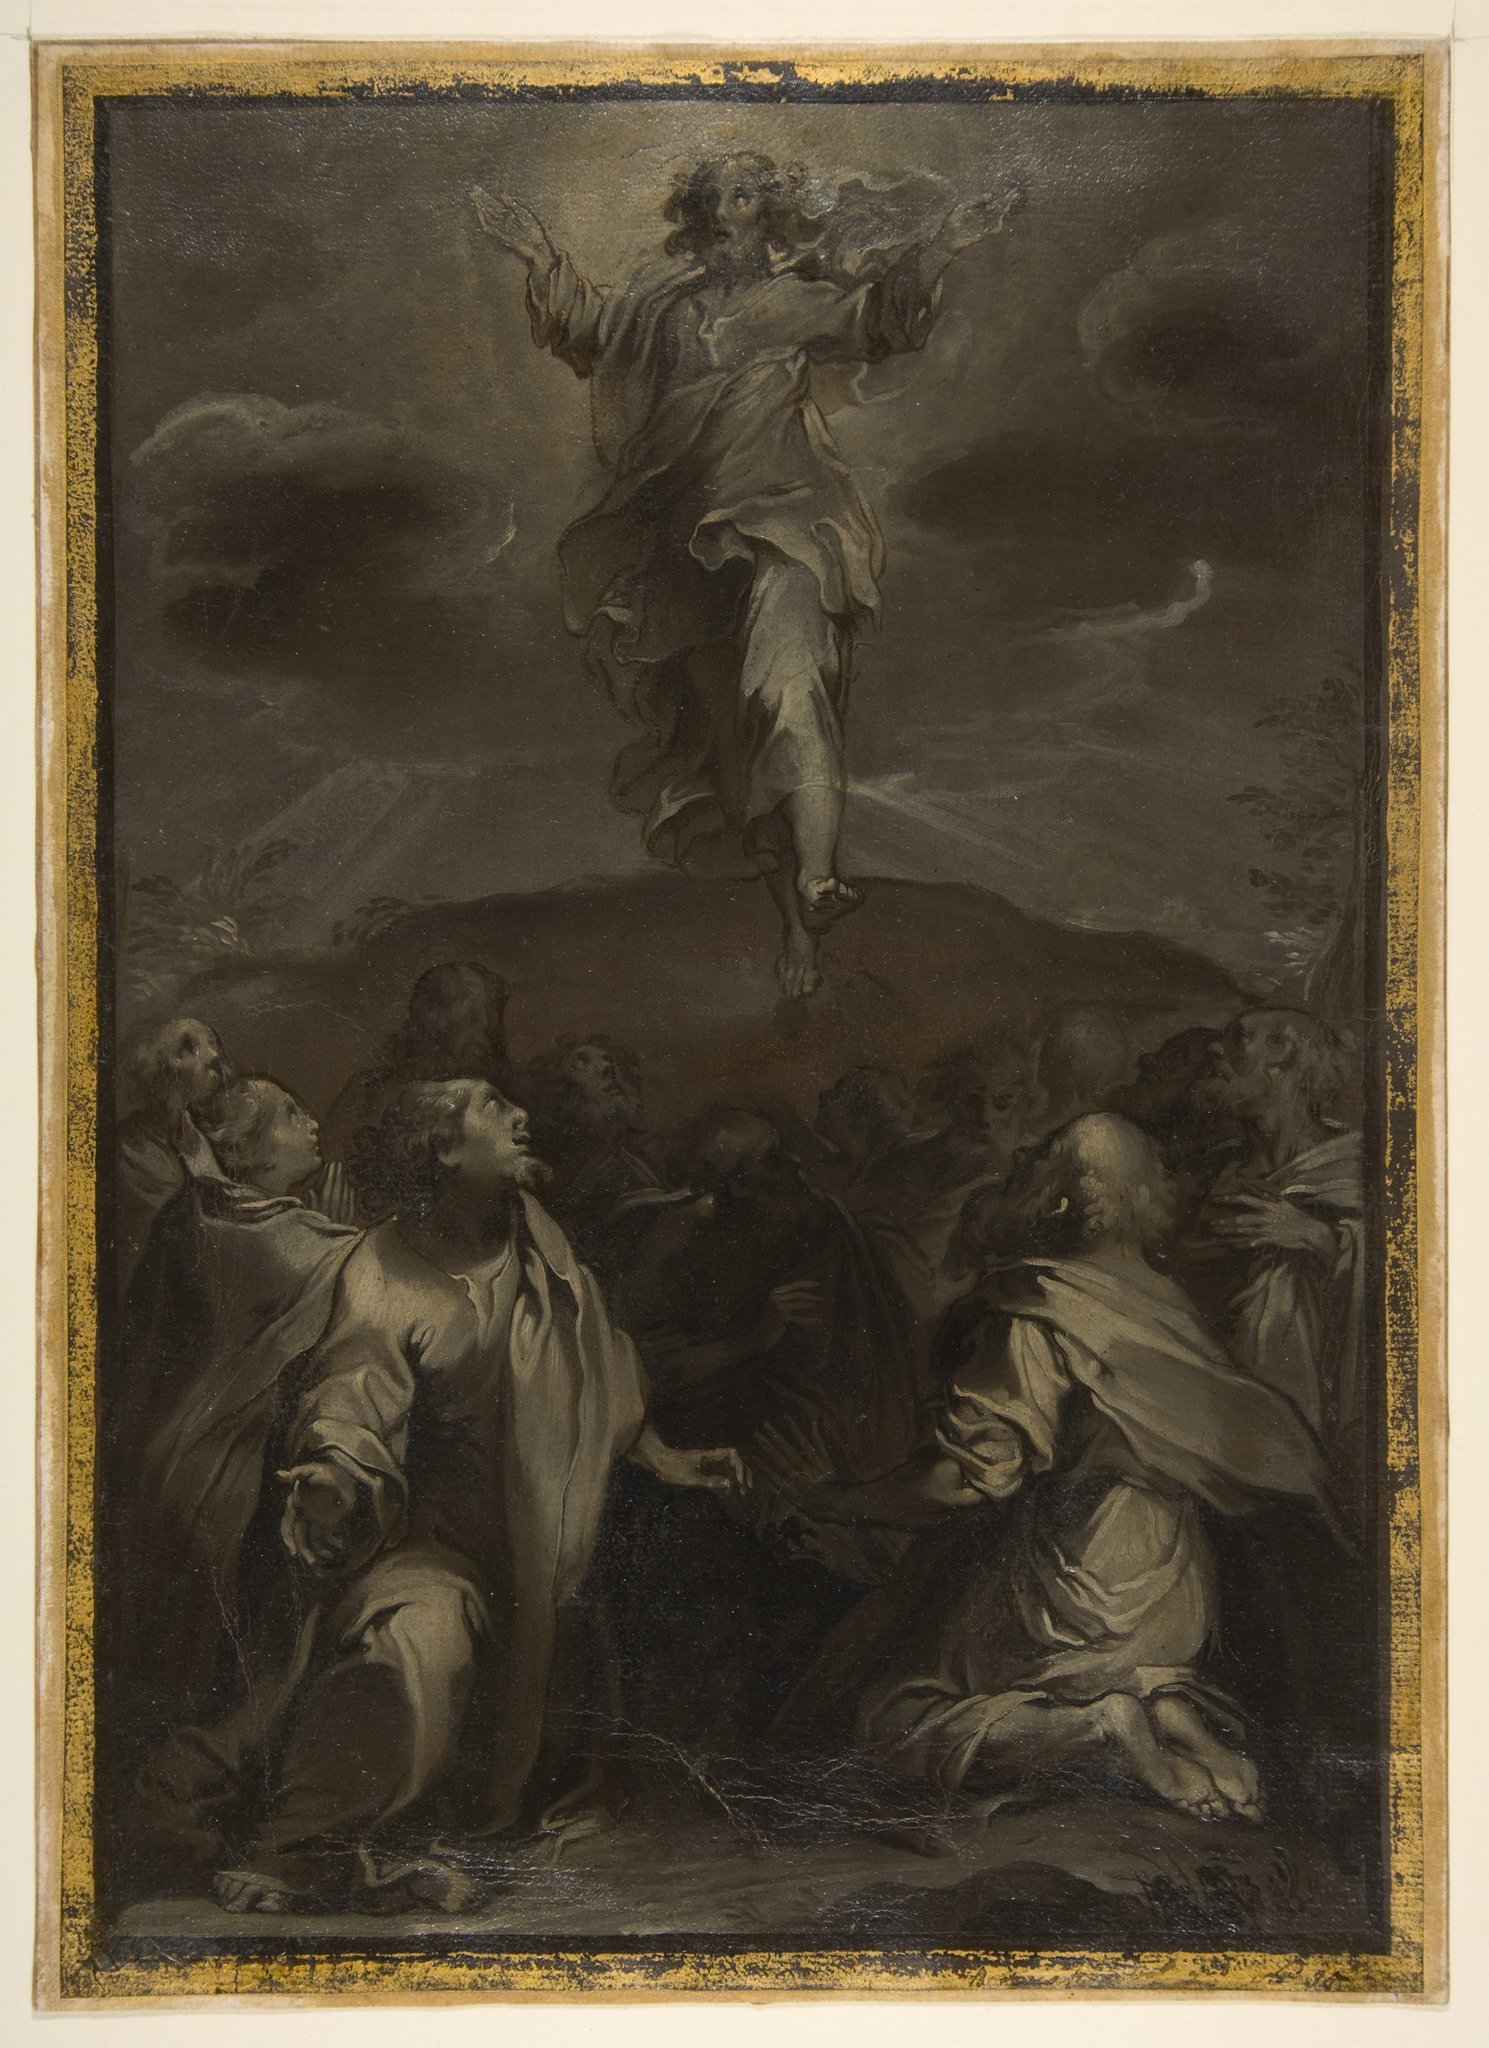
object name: drawing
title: The Ascension of Christ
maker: ventura salimbeni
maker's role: artist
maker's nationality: italian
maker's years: 1568-1613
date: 1568-1613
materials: oil, paper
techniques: brush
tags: men,christ